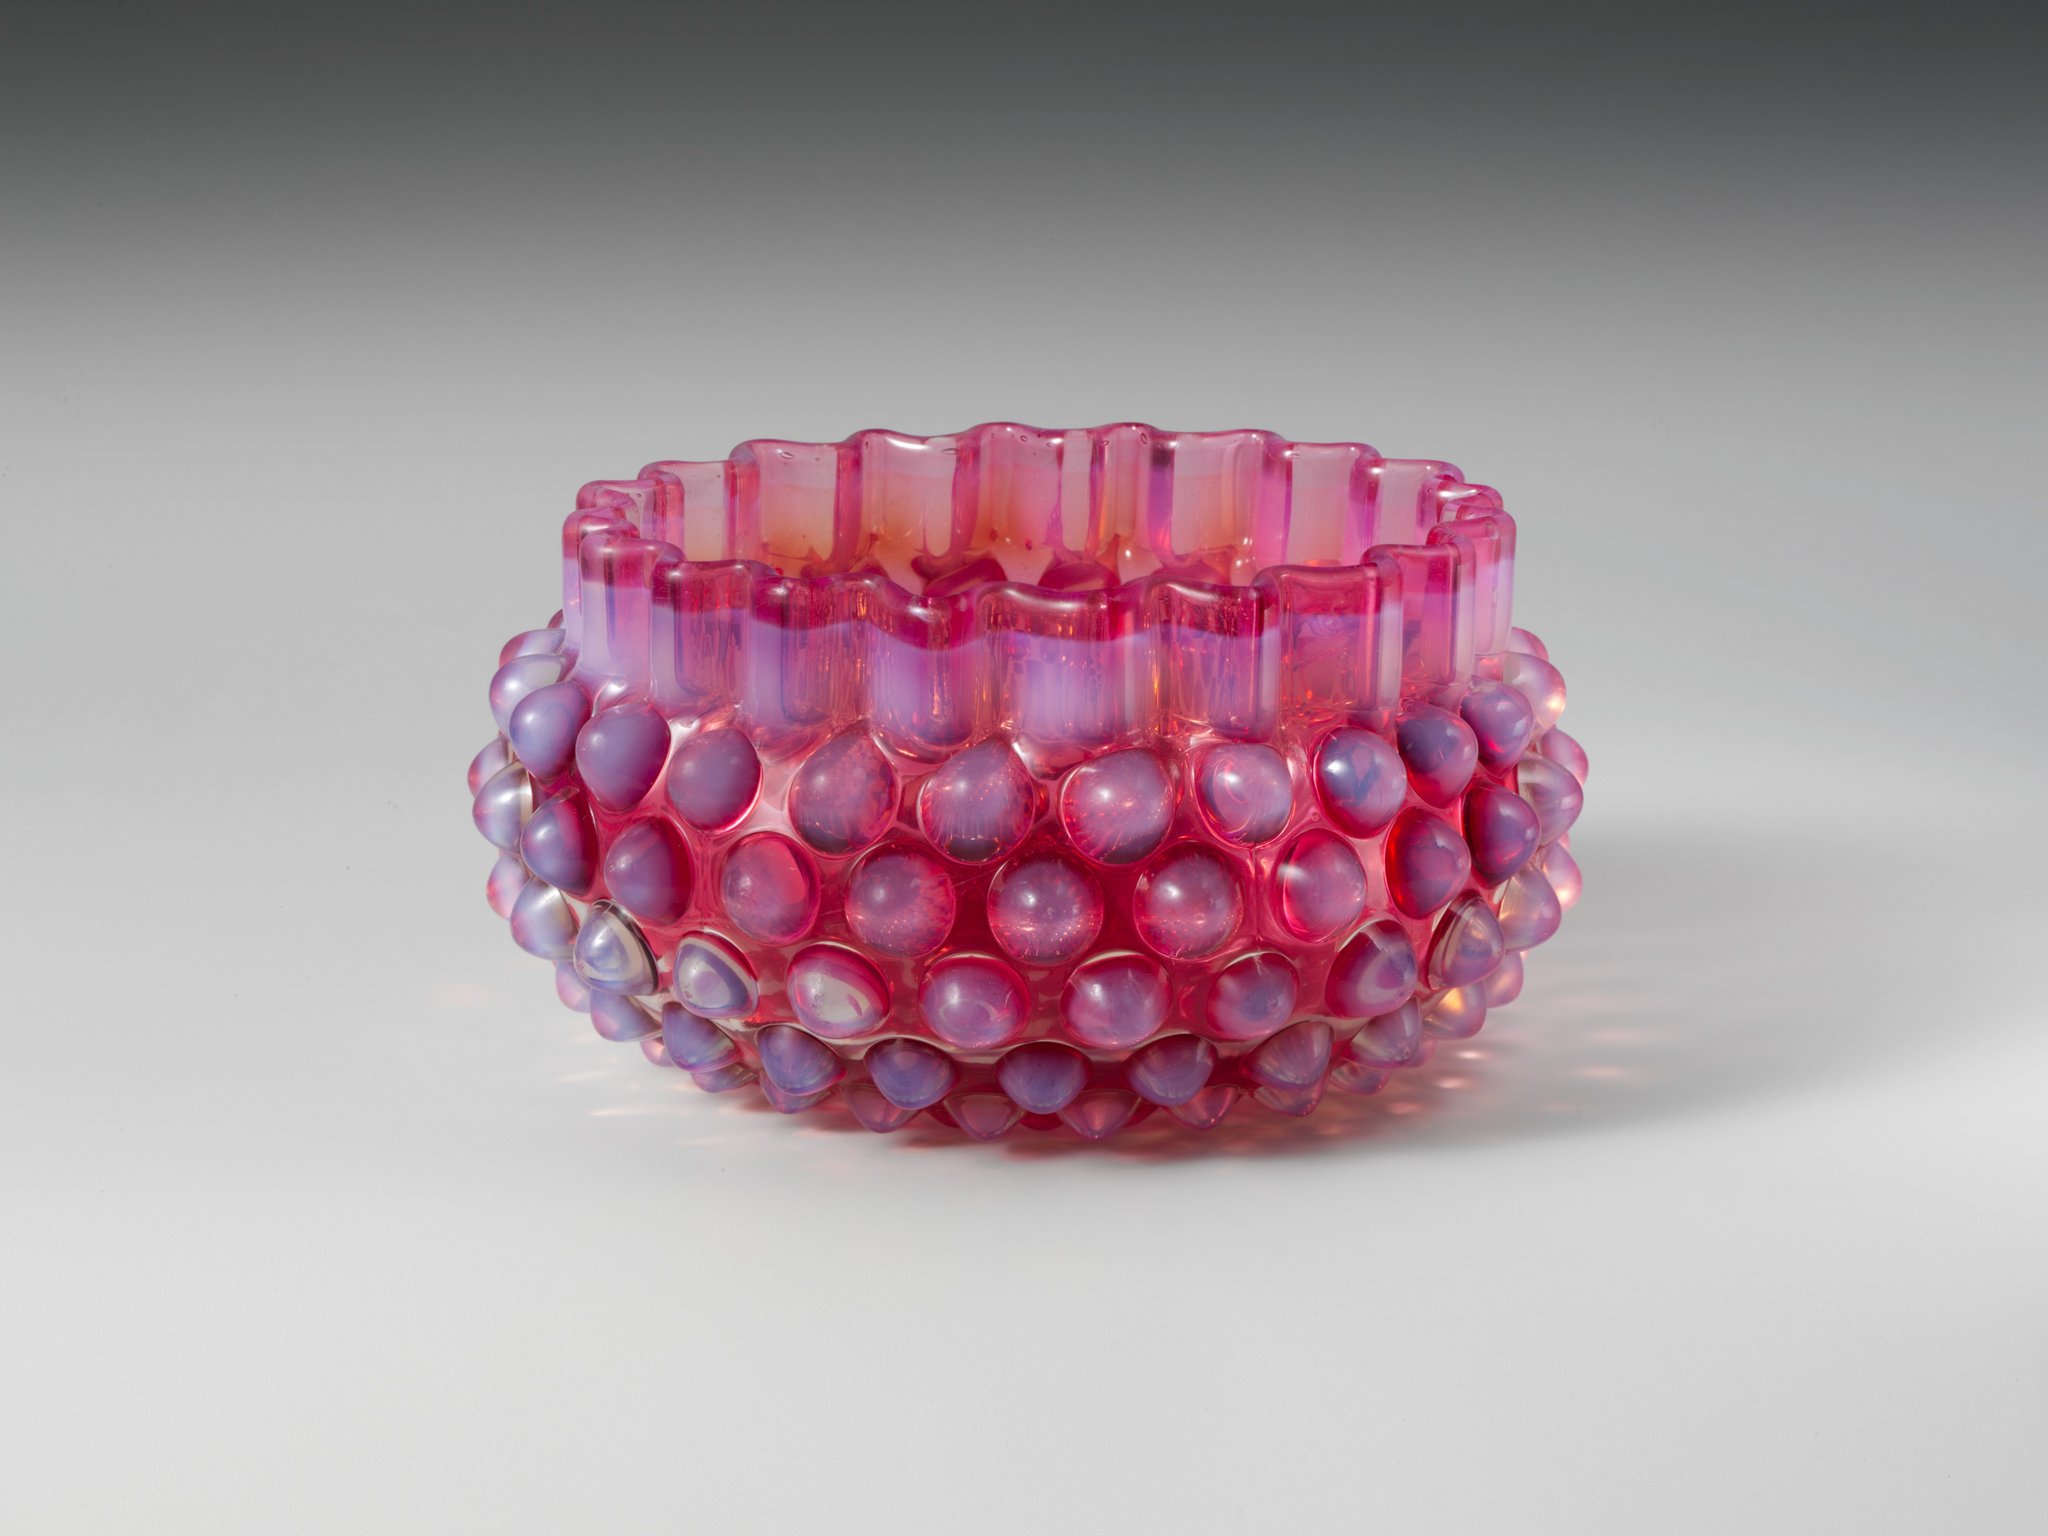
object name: finger bowl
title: Hobnail Finger Bowl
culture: american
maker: hobbs, brockunier and company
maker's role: maker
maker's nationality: american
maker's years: 1863-1891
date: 1886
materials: glass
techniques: pressed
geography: united states